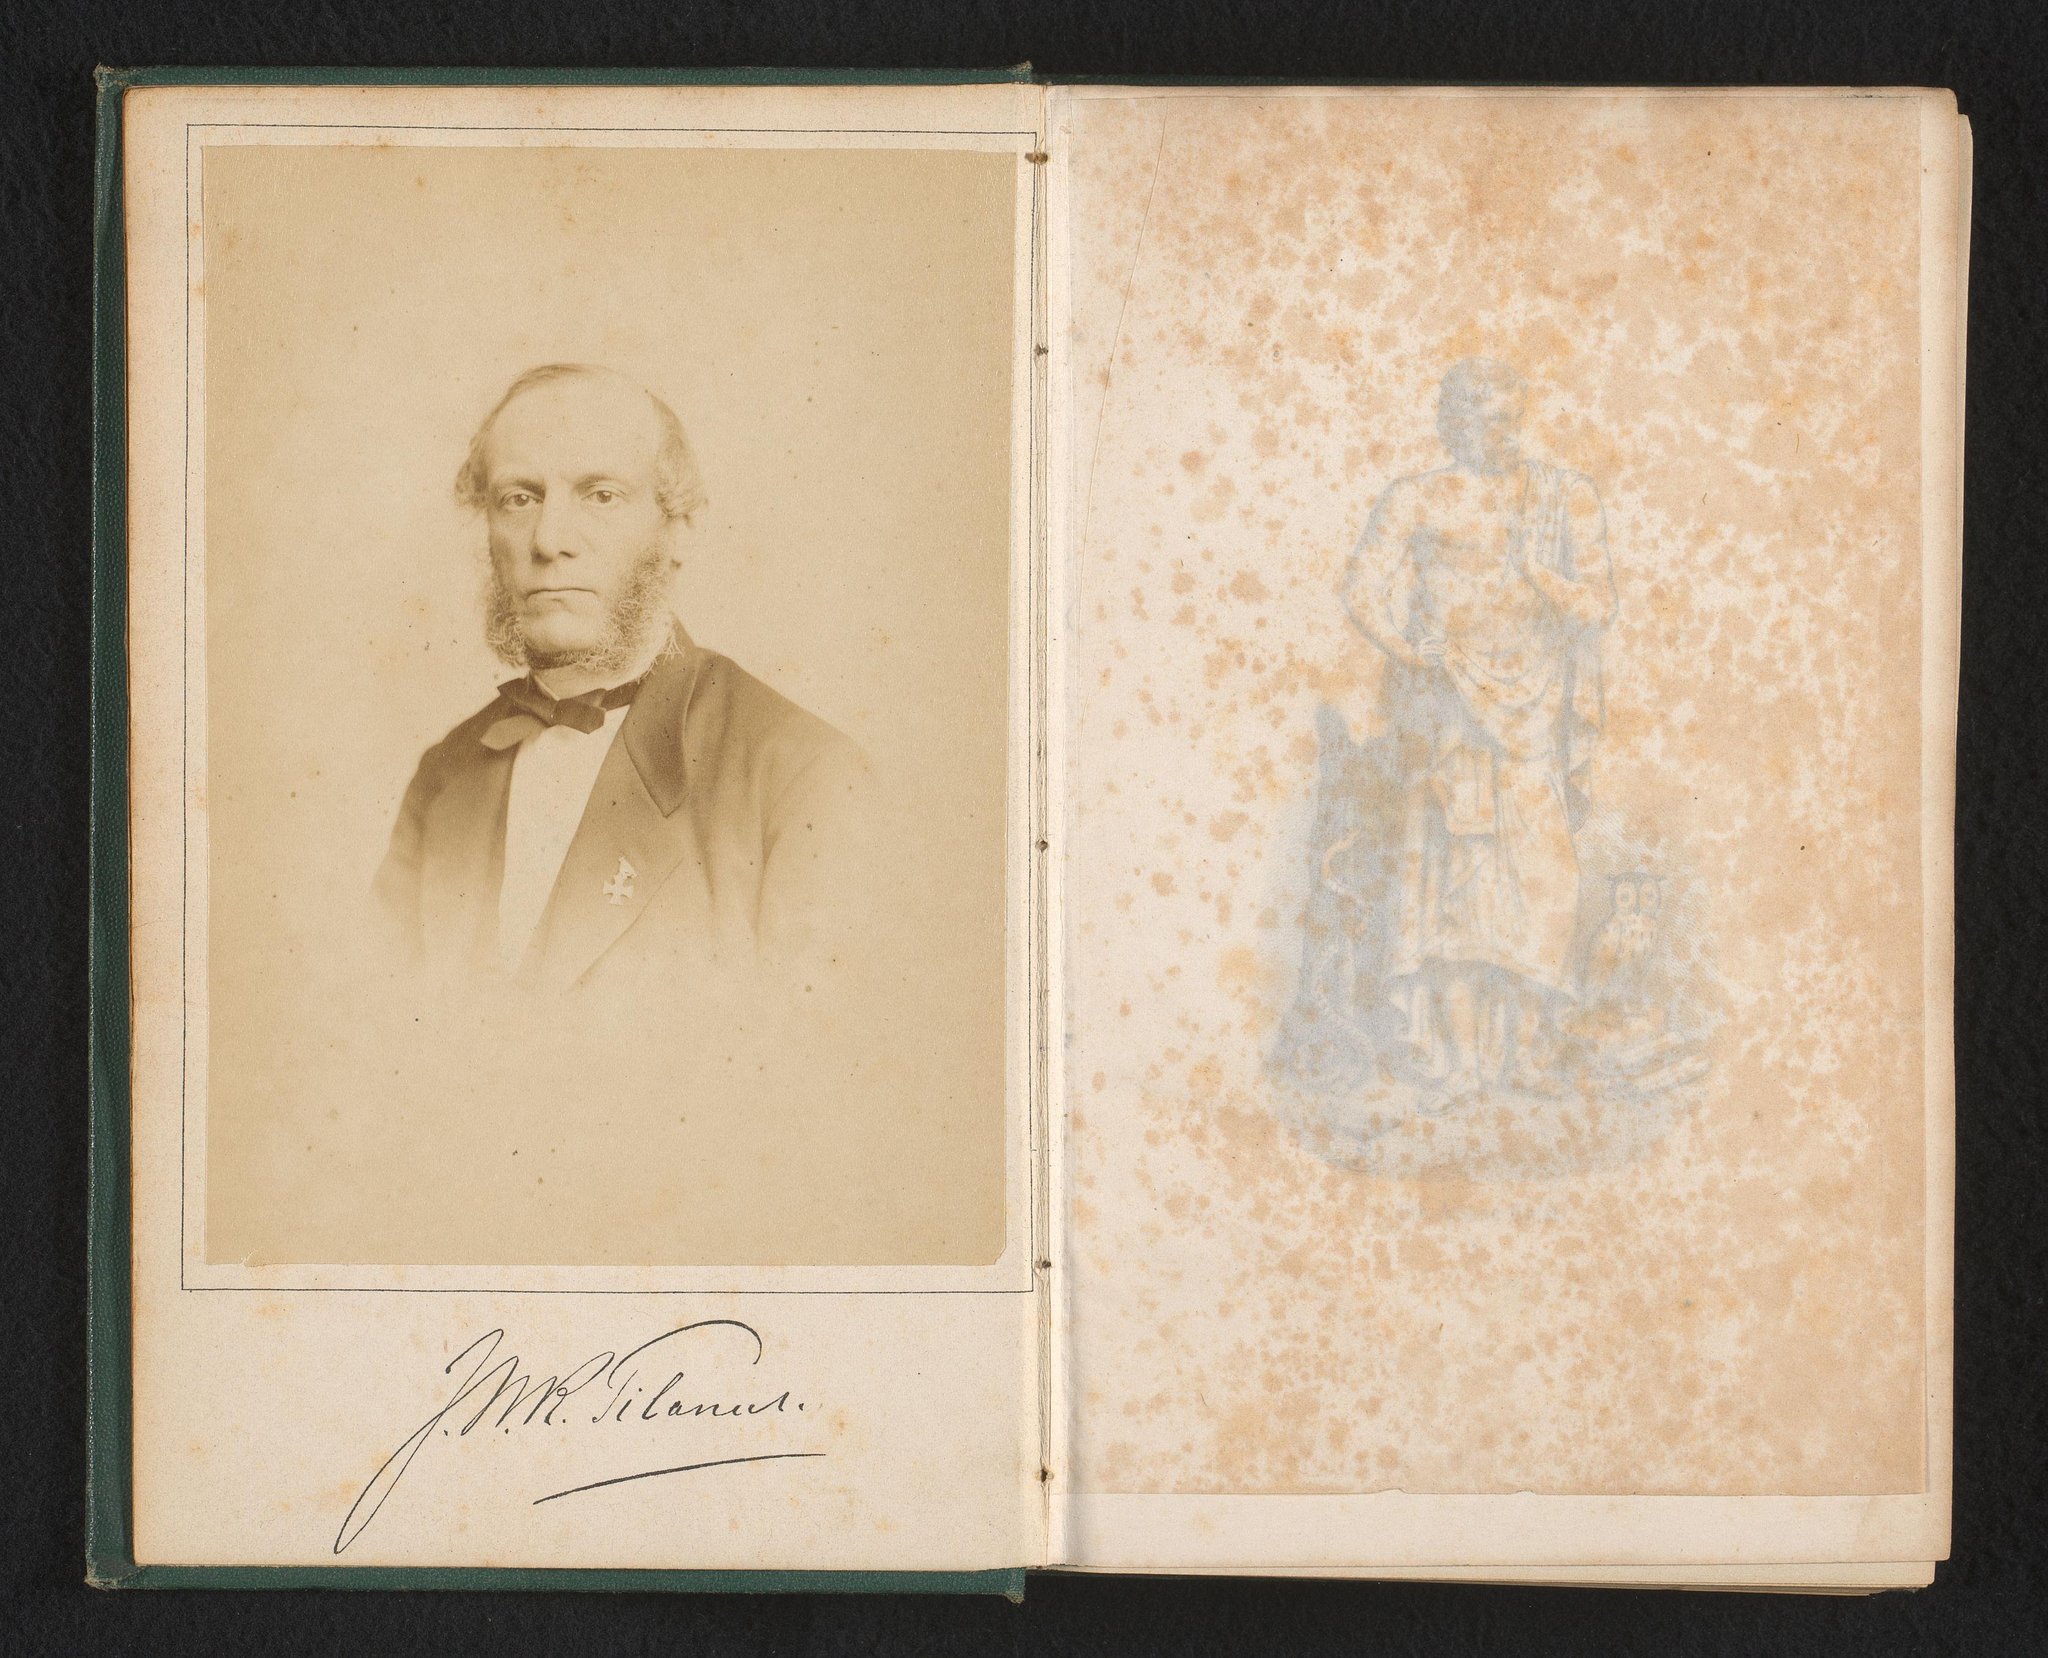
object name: page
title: Portret van Jan Willem Reinier Tilanus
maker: Anonymous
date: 1870-1875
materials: paper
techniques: albumen print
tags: arnhem, amsterdam, jan willem reinier tilanus, historical persons